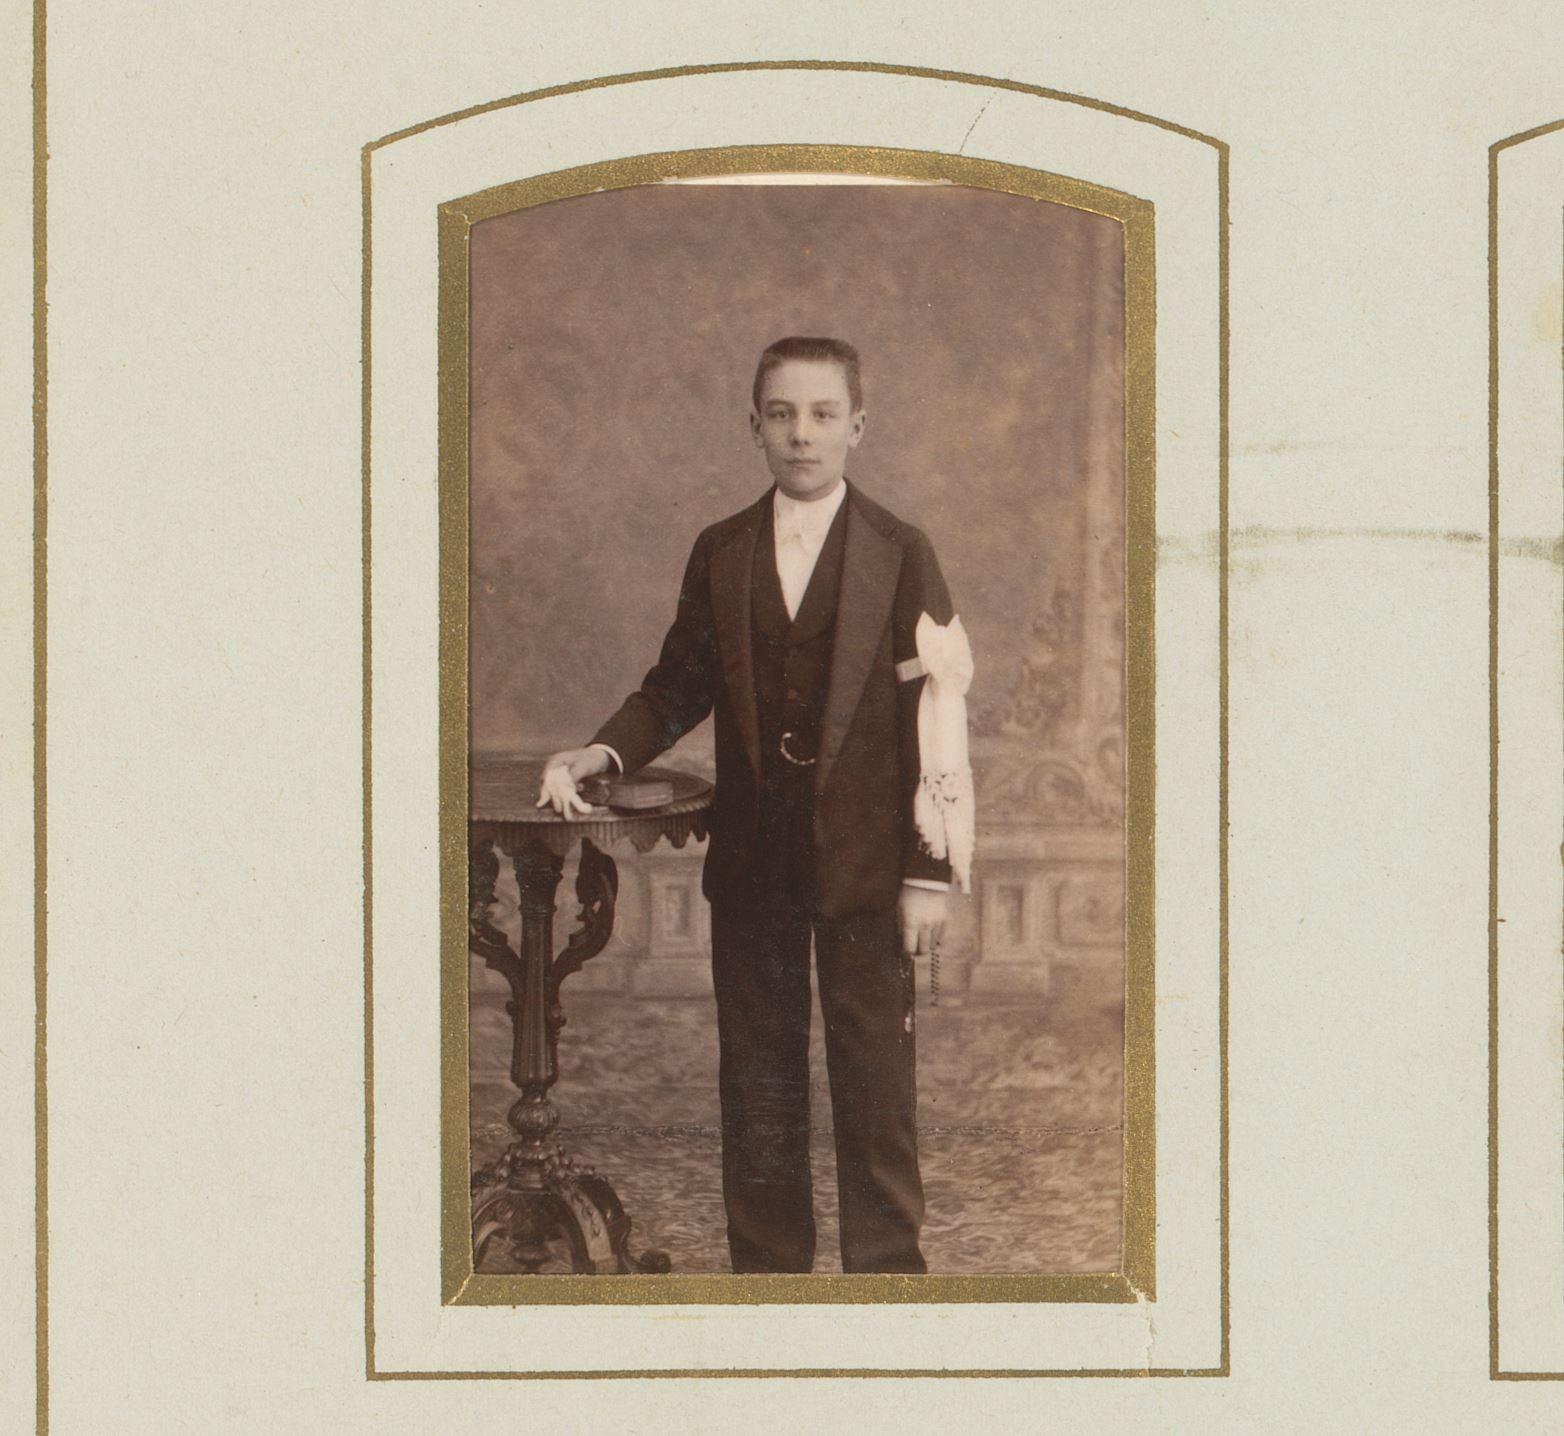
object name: photograph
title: Portret van een jongen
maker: louis sauvager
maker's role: fotograaf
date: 1889-1900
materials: cardboard, photographic support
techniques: albumen print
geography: fontainebleau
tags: boy (child between toddler and youth), historical persons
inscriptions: inscription: ‘Louis Sauvager/ Rue Grande 193, Fontainebleau/ MÉDAILLES AUX EXPOSITIONS UNIVER[SELLE]/ 1878 Paris 1889/ BRONZE ARGENT/ MÉDAILLE D'OR/ Exposition Artistique de Melun./ NOTA: Tous les Clichés sont conservés./ et l'on peut avec ces clichés faire de Grands Portraits Inaltérables.’